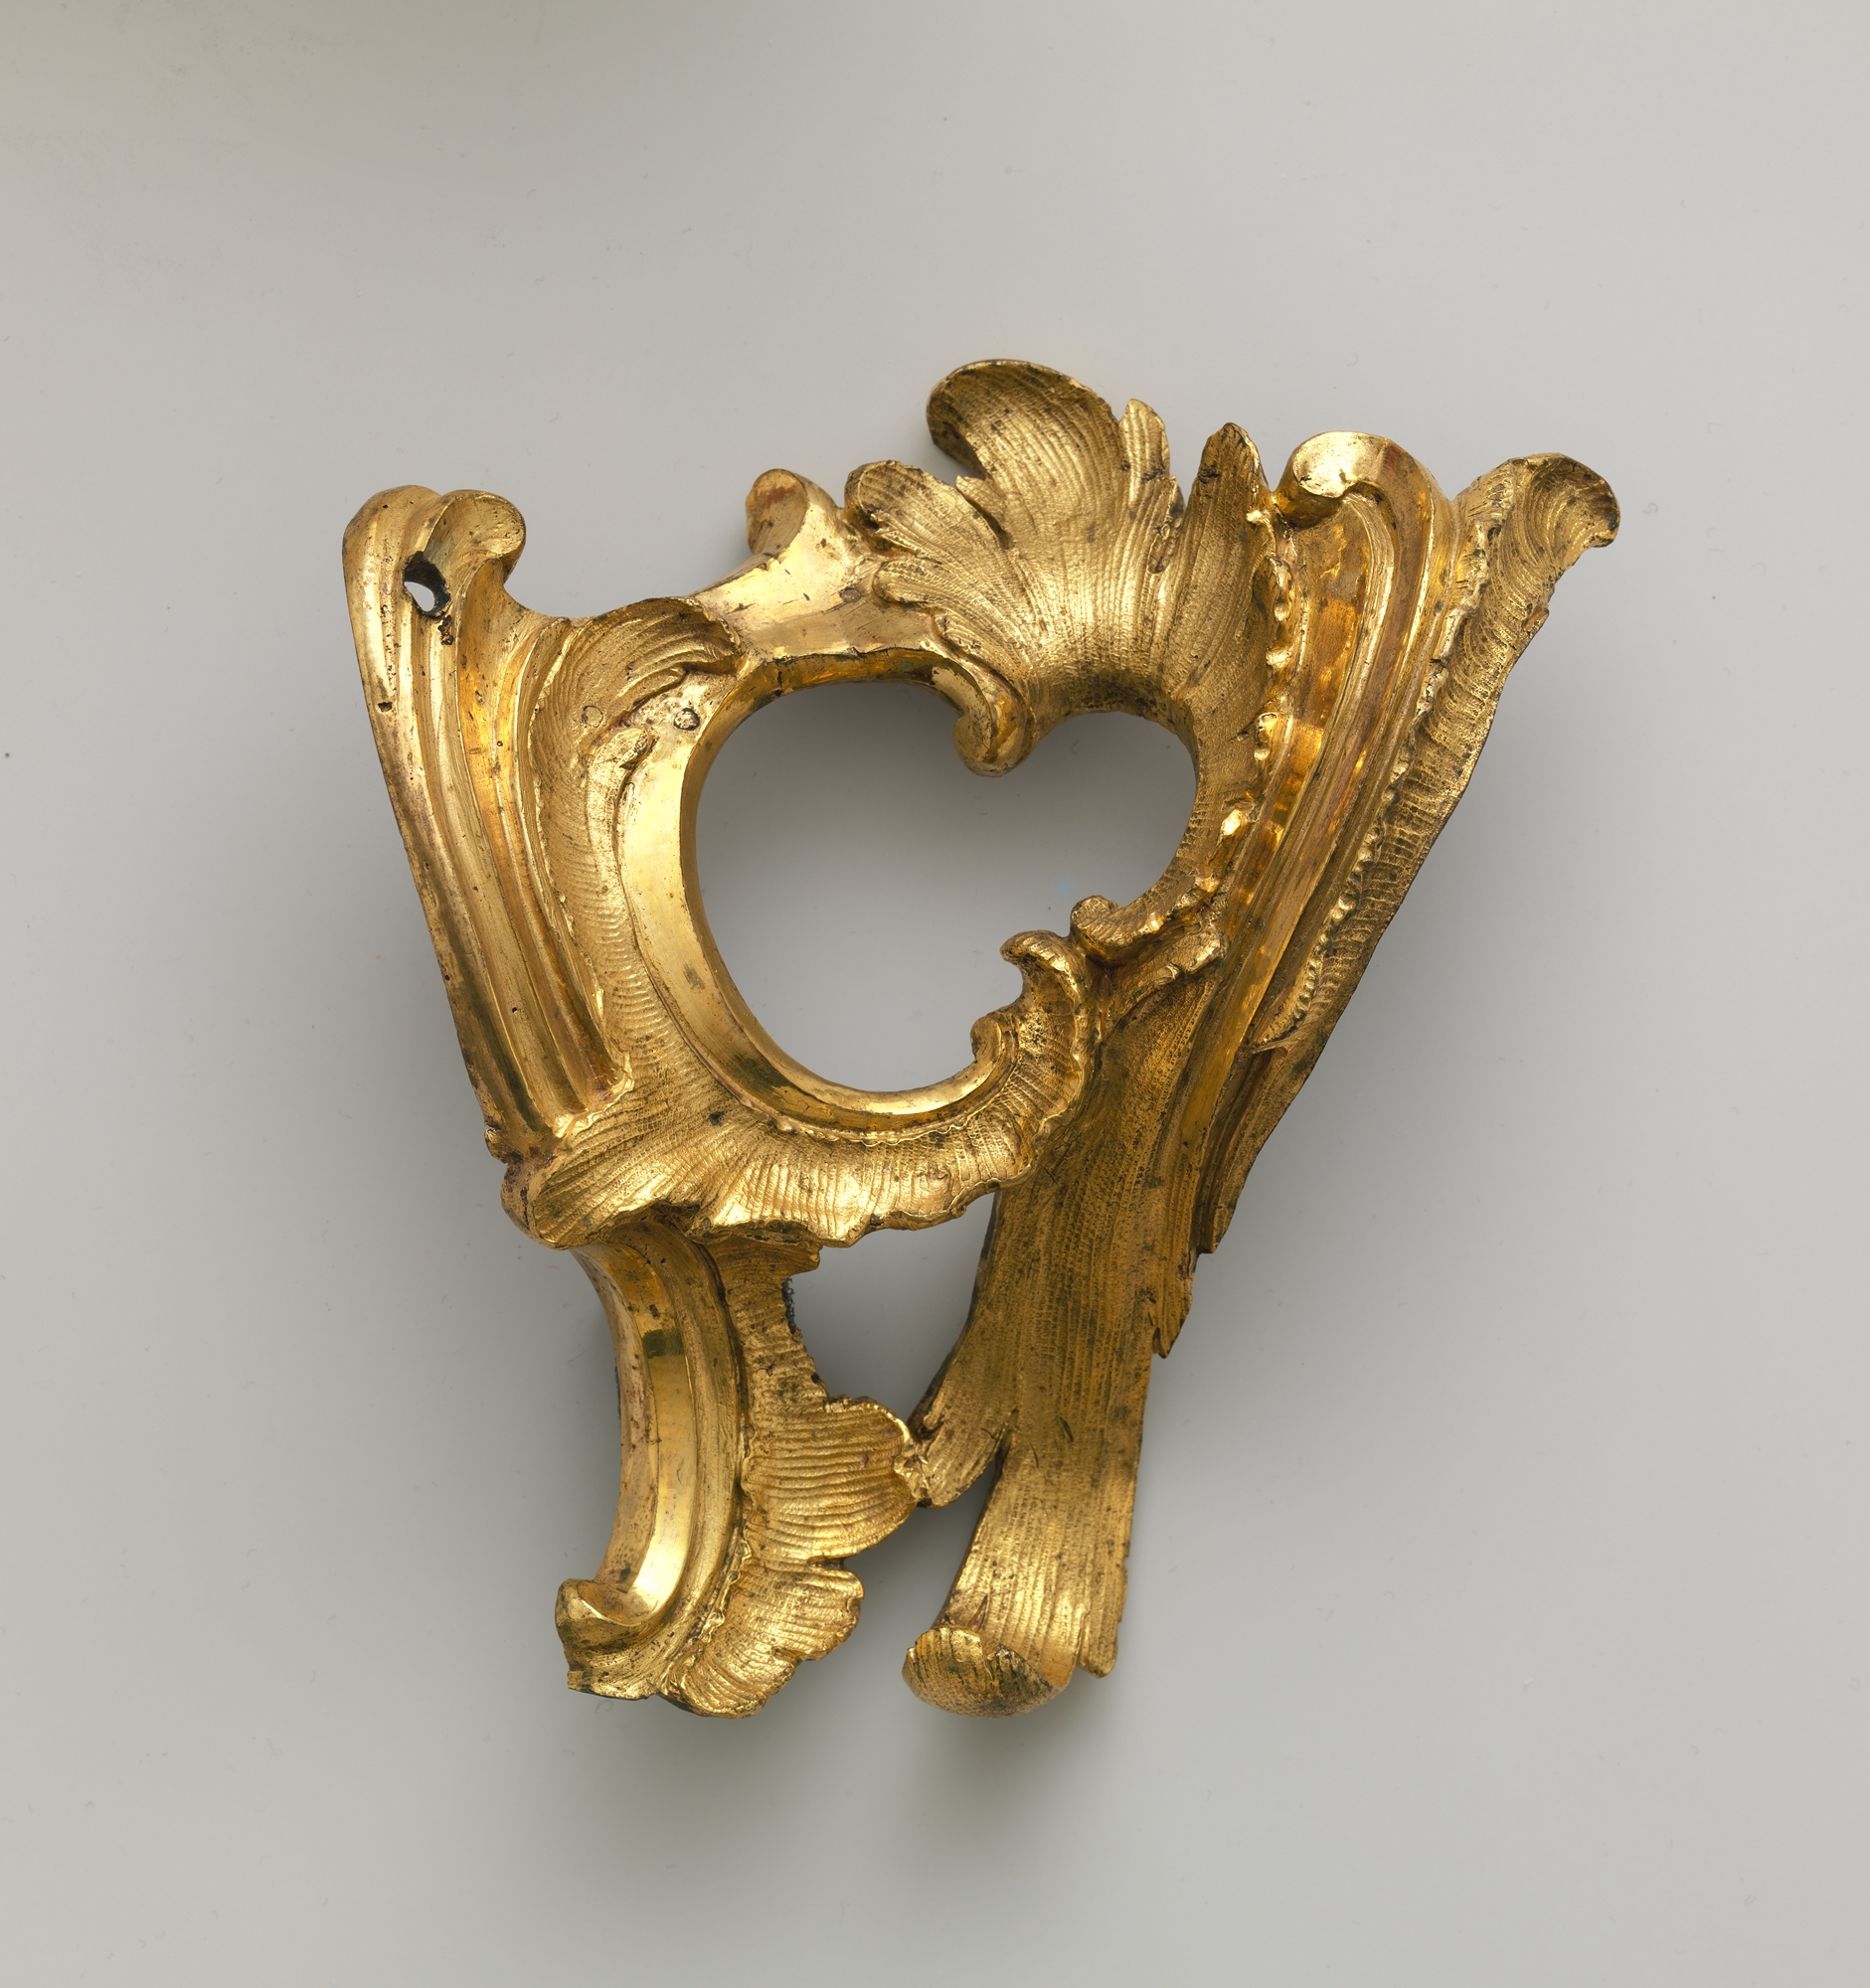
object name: corner ornament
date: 1701-1800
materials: gilt bronze